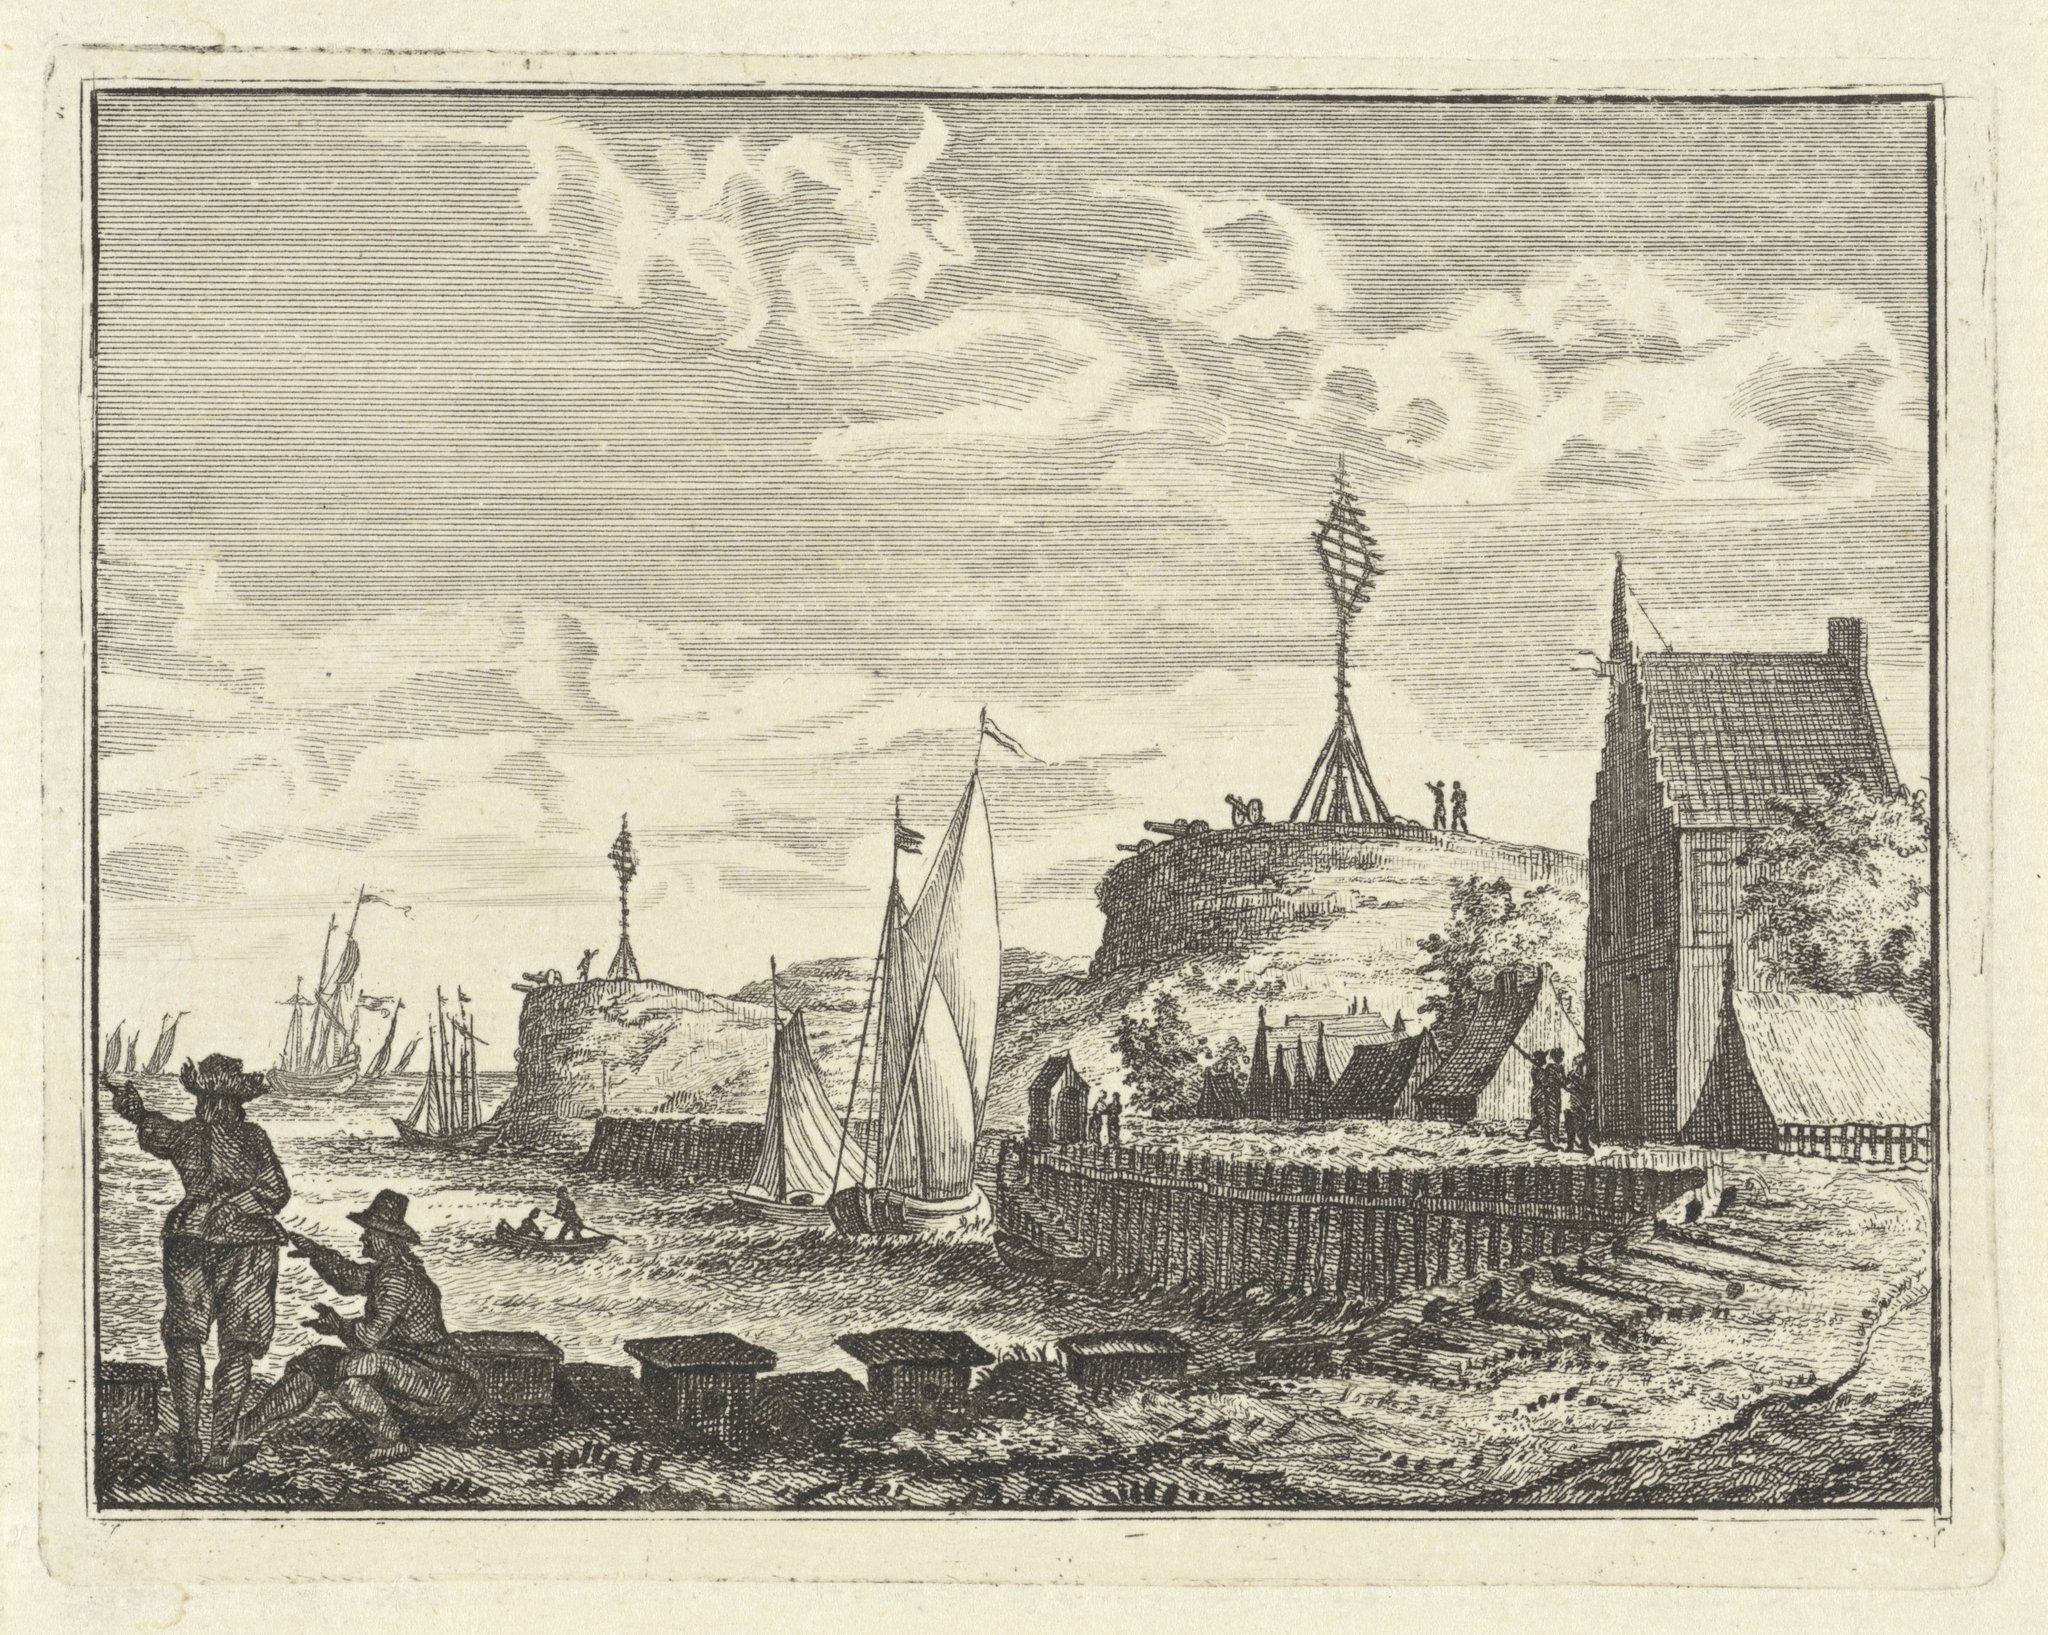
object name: print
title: Kust met uitkijkpost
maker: vincent laurensz. van der vinne (ii)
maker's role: draughtsman, print maker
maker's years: 1686-1742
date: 1714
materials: paper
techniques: etching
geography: haarlem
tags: harbour, beacon, index finger forwards, pointing, indicating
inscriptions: collector's mark: Lugt 240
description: Prent oorspronkelijk bedoeld als boekillustratie voor: Spinniker, Adriaan. Leerzaame zinnebeelden. Haarlem: [boekverkoper] Isaak van der Vinne (I) en Amsterdam: [drukker] Johannes Krelius, 1714. Later gebruikt als boekillustratie in: Spinniker, Adriaan. Vervolg der leerzaame zinnebeelden, : spiegel der boetvaardigheid en genade en eenige Stichtelyke gezangen. Haarlem: Jan Bosch, 1758.